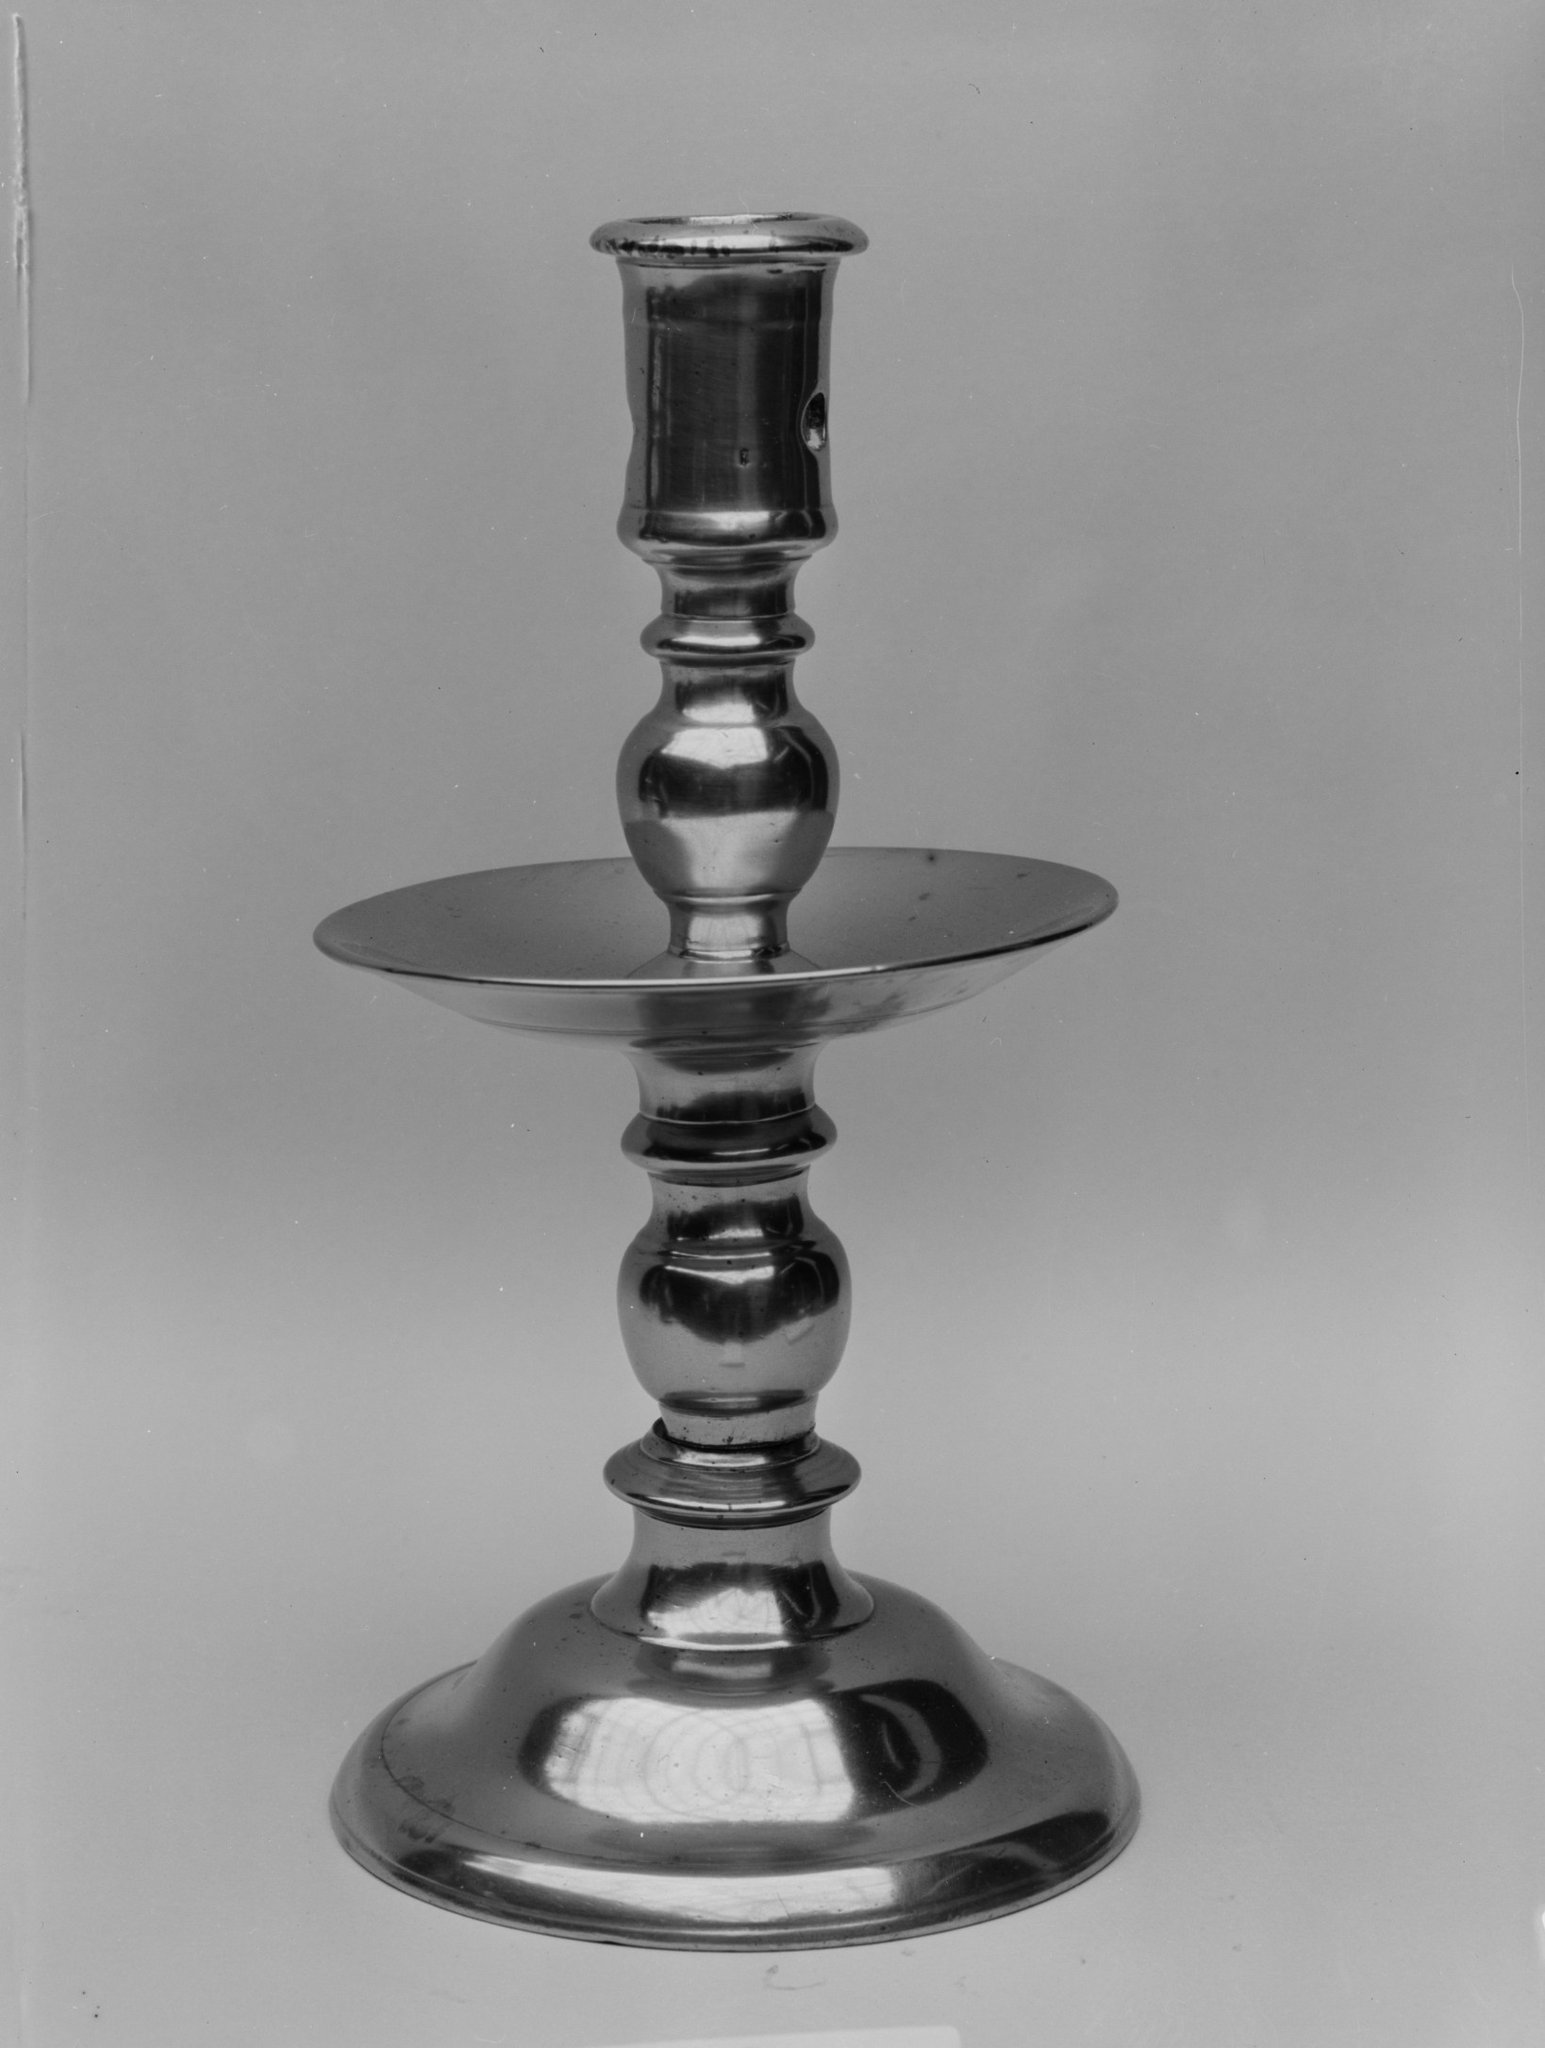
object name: candlestick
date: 1600-1700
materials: brass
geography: netherlands